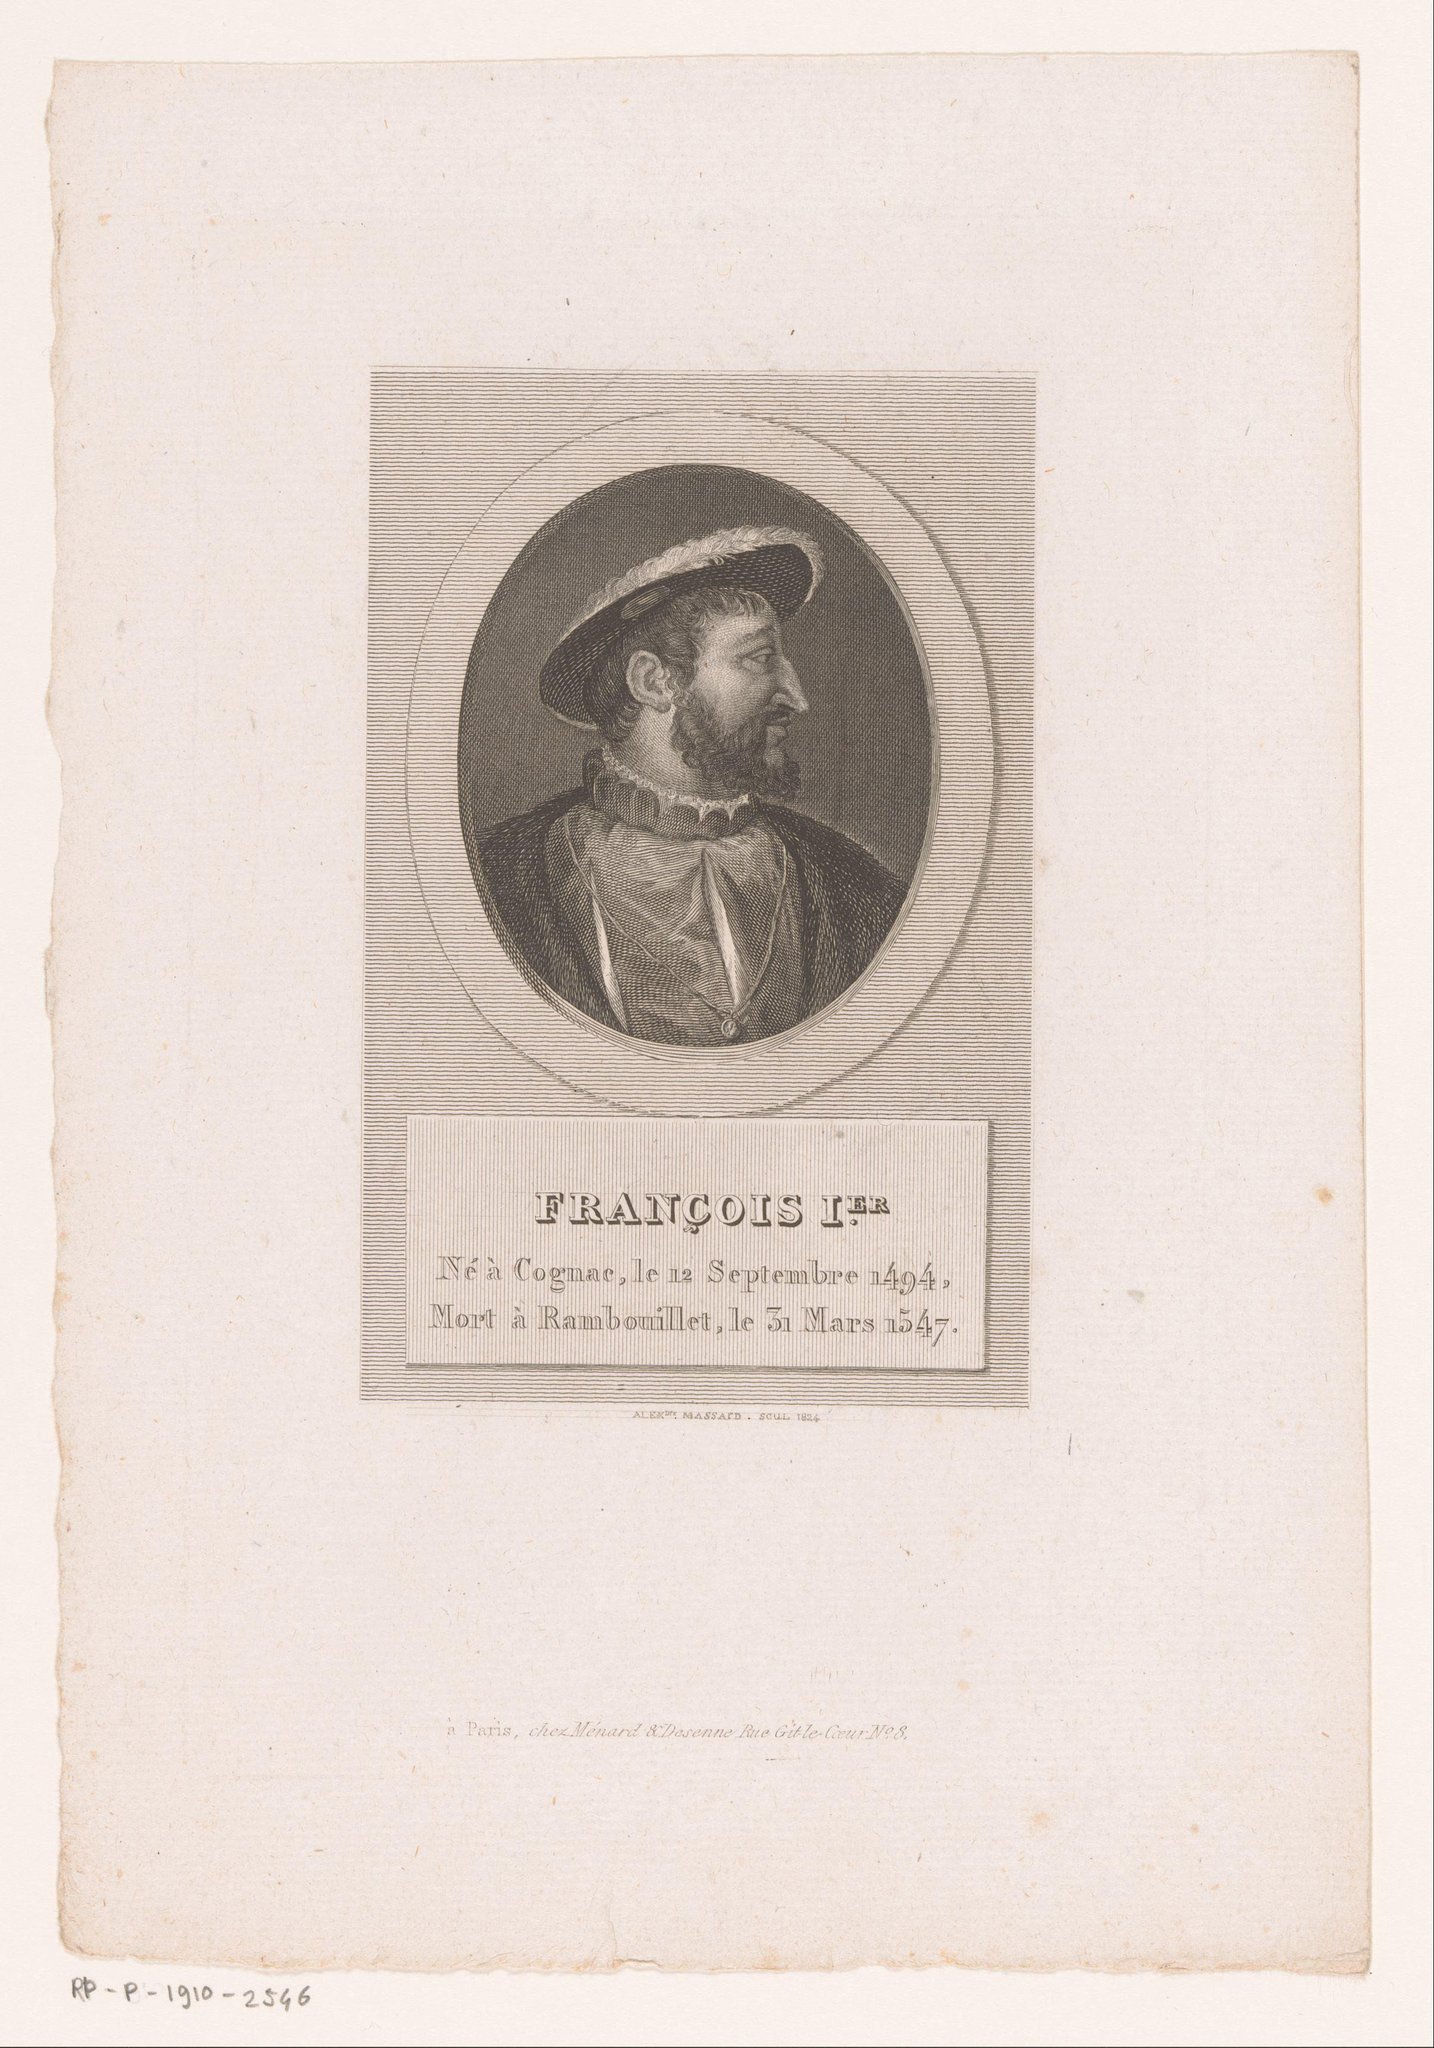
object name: print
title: Portret van Frans I van Valois-Angoulême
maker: alexandre massard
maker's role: print maker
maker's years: 1777-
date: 1824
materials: paper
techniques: engraving, etching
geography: paris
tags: frans i van valois-angoulême (koning van frankrijk), historical persons, king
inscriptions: collector's mark: Lugt 2228